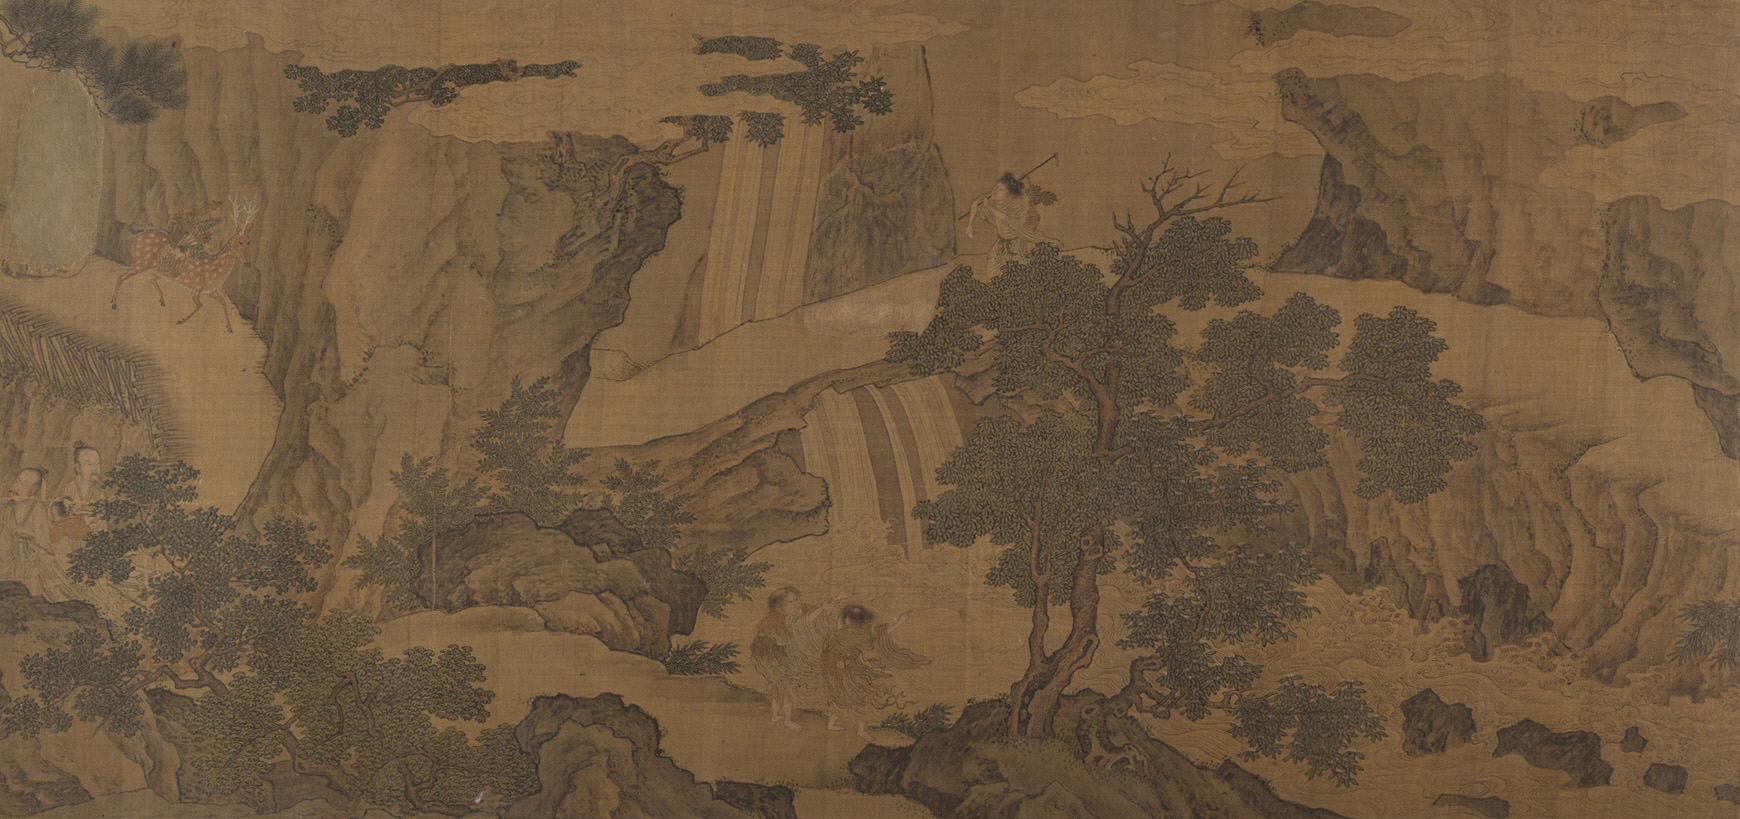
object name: handscroll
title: Daoist immortals in a landscape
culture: chinese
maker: unidentified artist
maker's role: artist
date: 1501-1600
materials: ink, silk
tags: men,landscapes